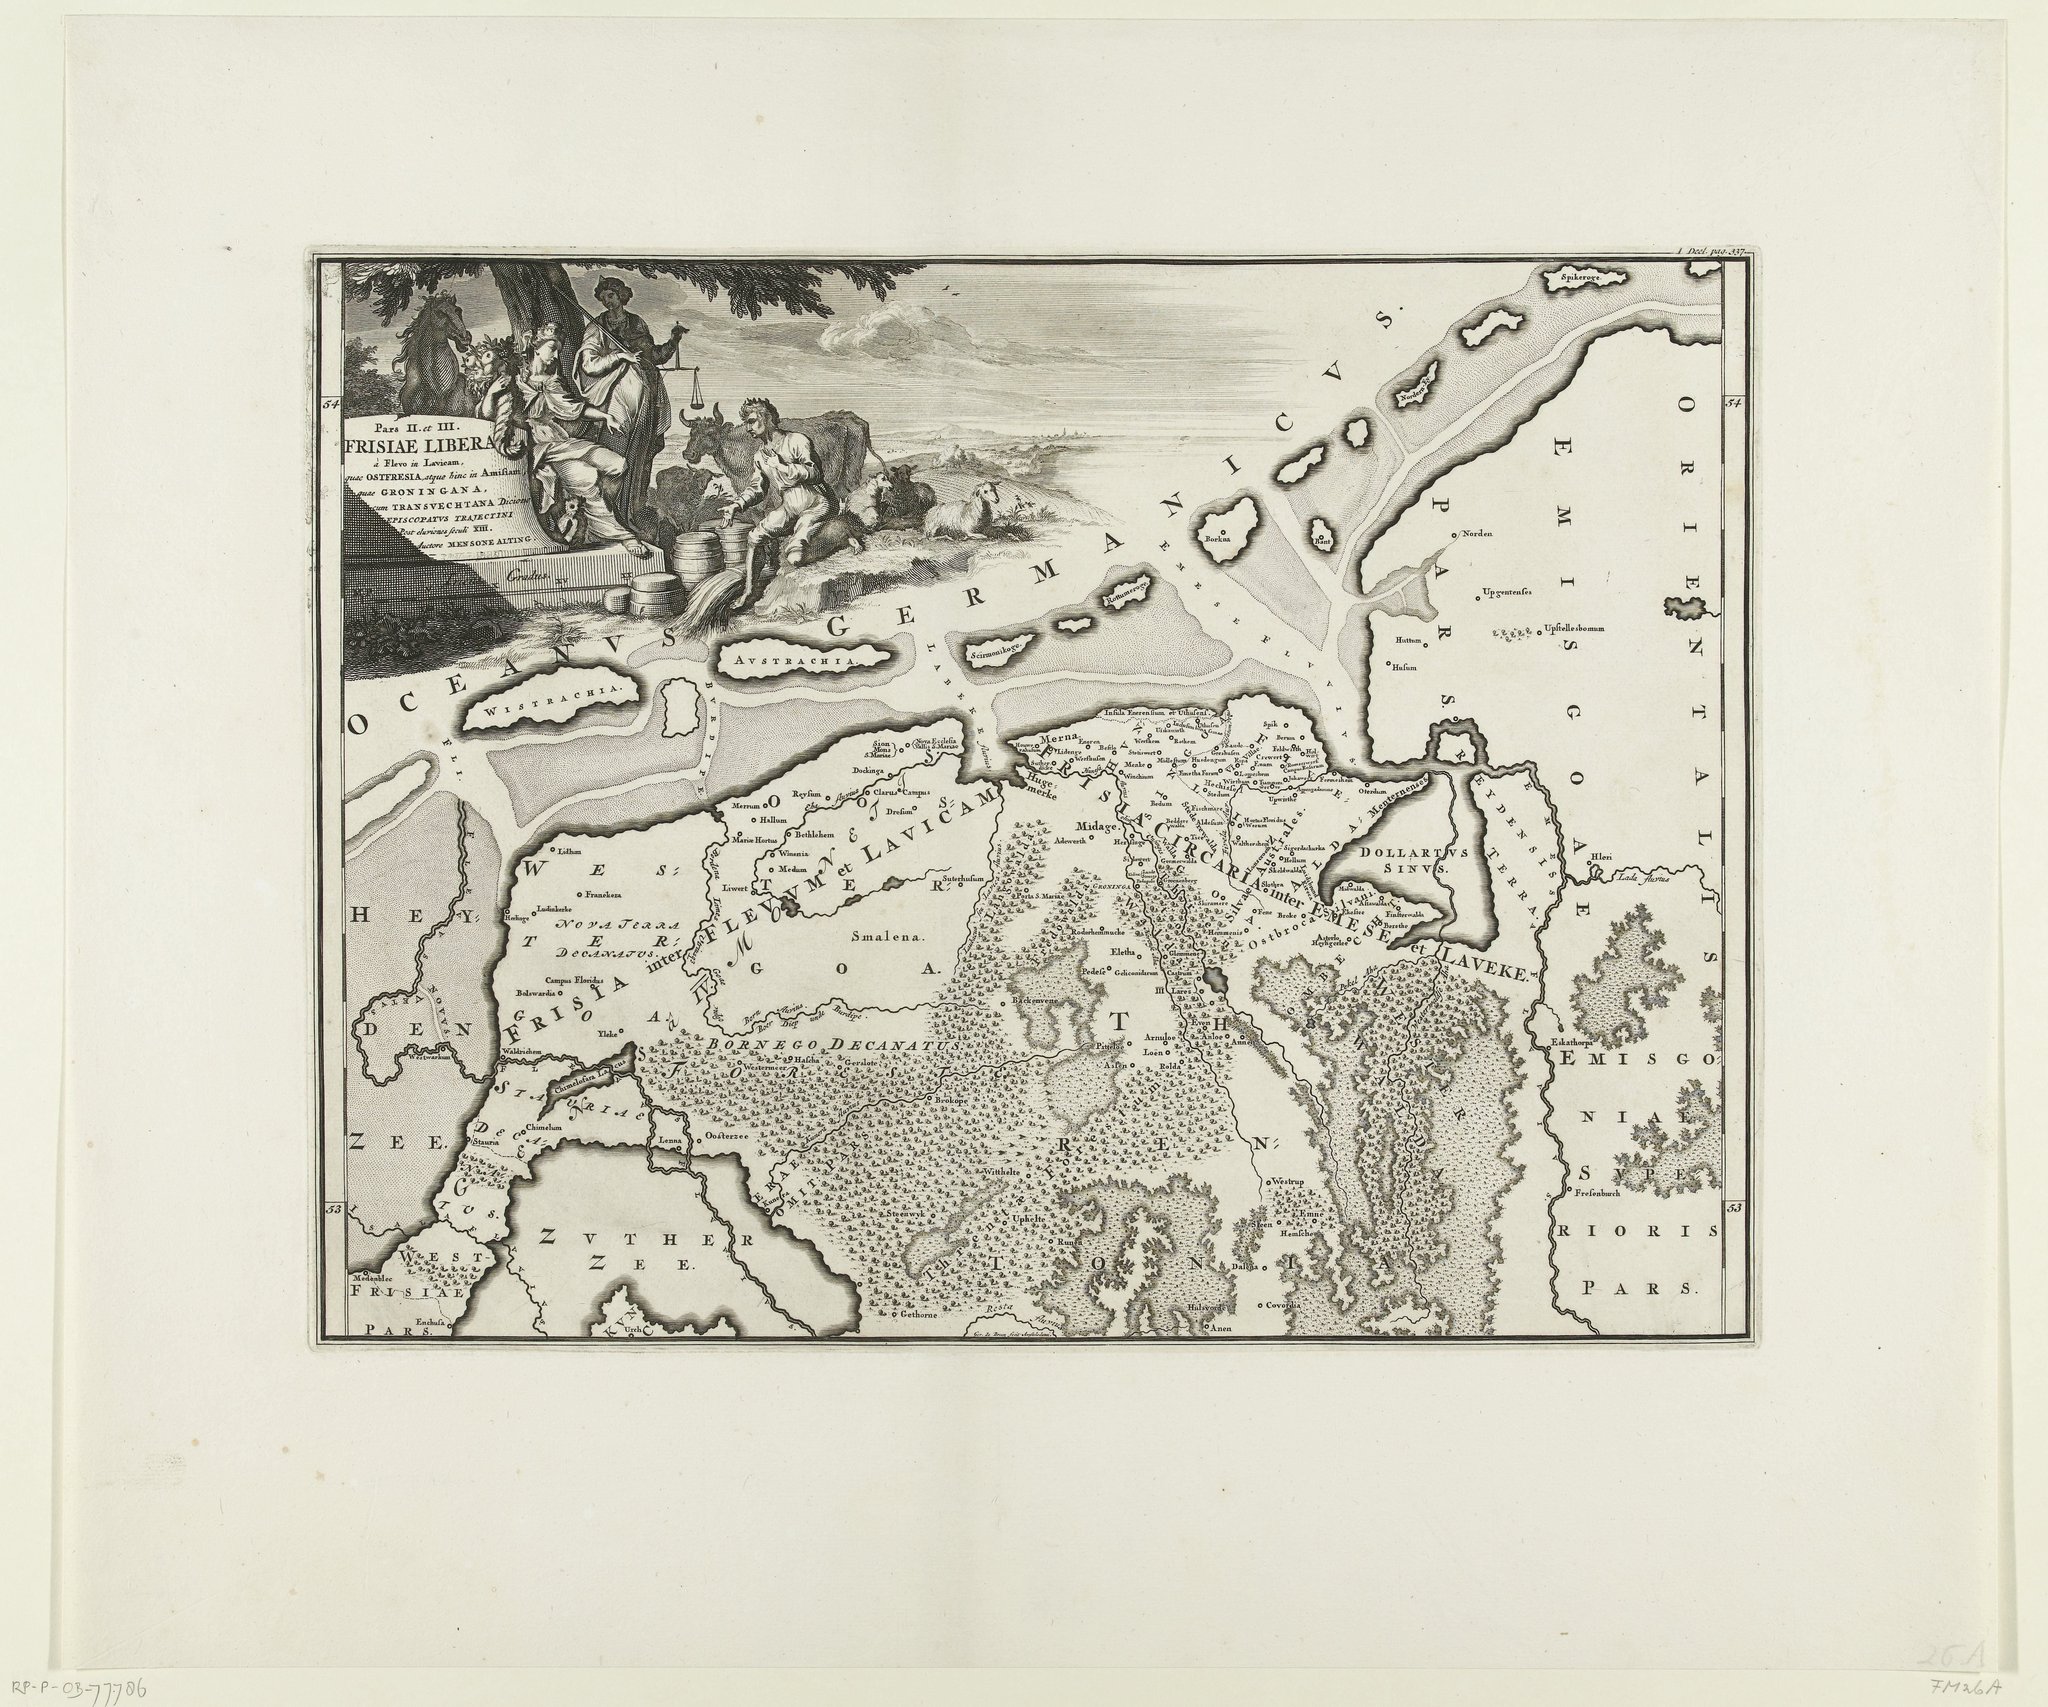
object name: history print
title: Historische kaart van Nederland met de gebieden van de Bataven en Friezen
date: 1695-1700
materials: paper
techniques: engraving, etching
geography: netherlands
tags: maps of separate countries or regions, netherlands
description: Kaart van de Friese gebieden in noordelijk Nederland. Maakt deel uit van 16 kaarten van het land van de Bataven en de Friezen eerst vervaardigd voor en opgenomen in M. Alting, Descriptio ant. agri Batavi et Frisii, s. notitia Germ. infer., 2 delen, 1697-1700. Hergebruikt in F. Halma, Tooneel der Vereenigde Nederlanden en onderhorige landschappen, geopent in een algemeen historisch, genealogisch, geographisch en staatkundig woordenboek, 2 delen, 1725. Volgens opschrift geplaatst in: Deel I, pag. 337.